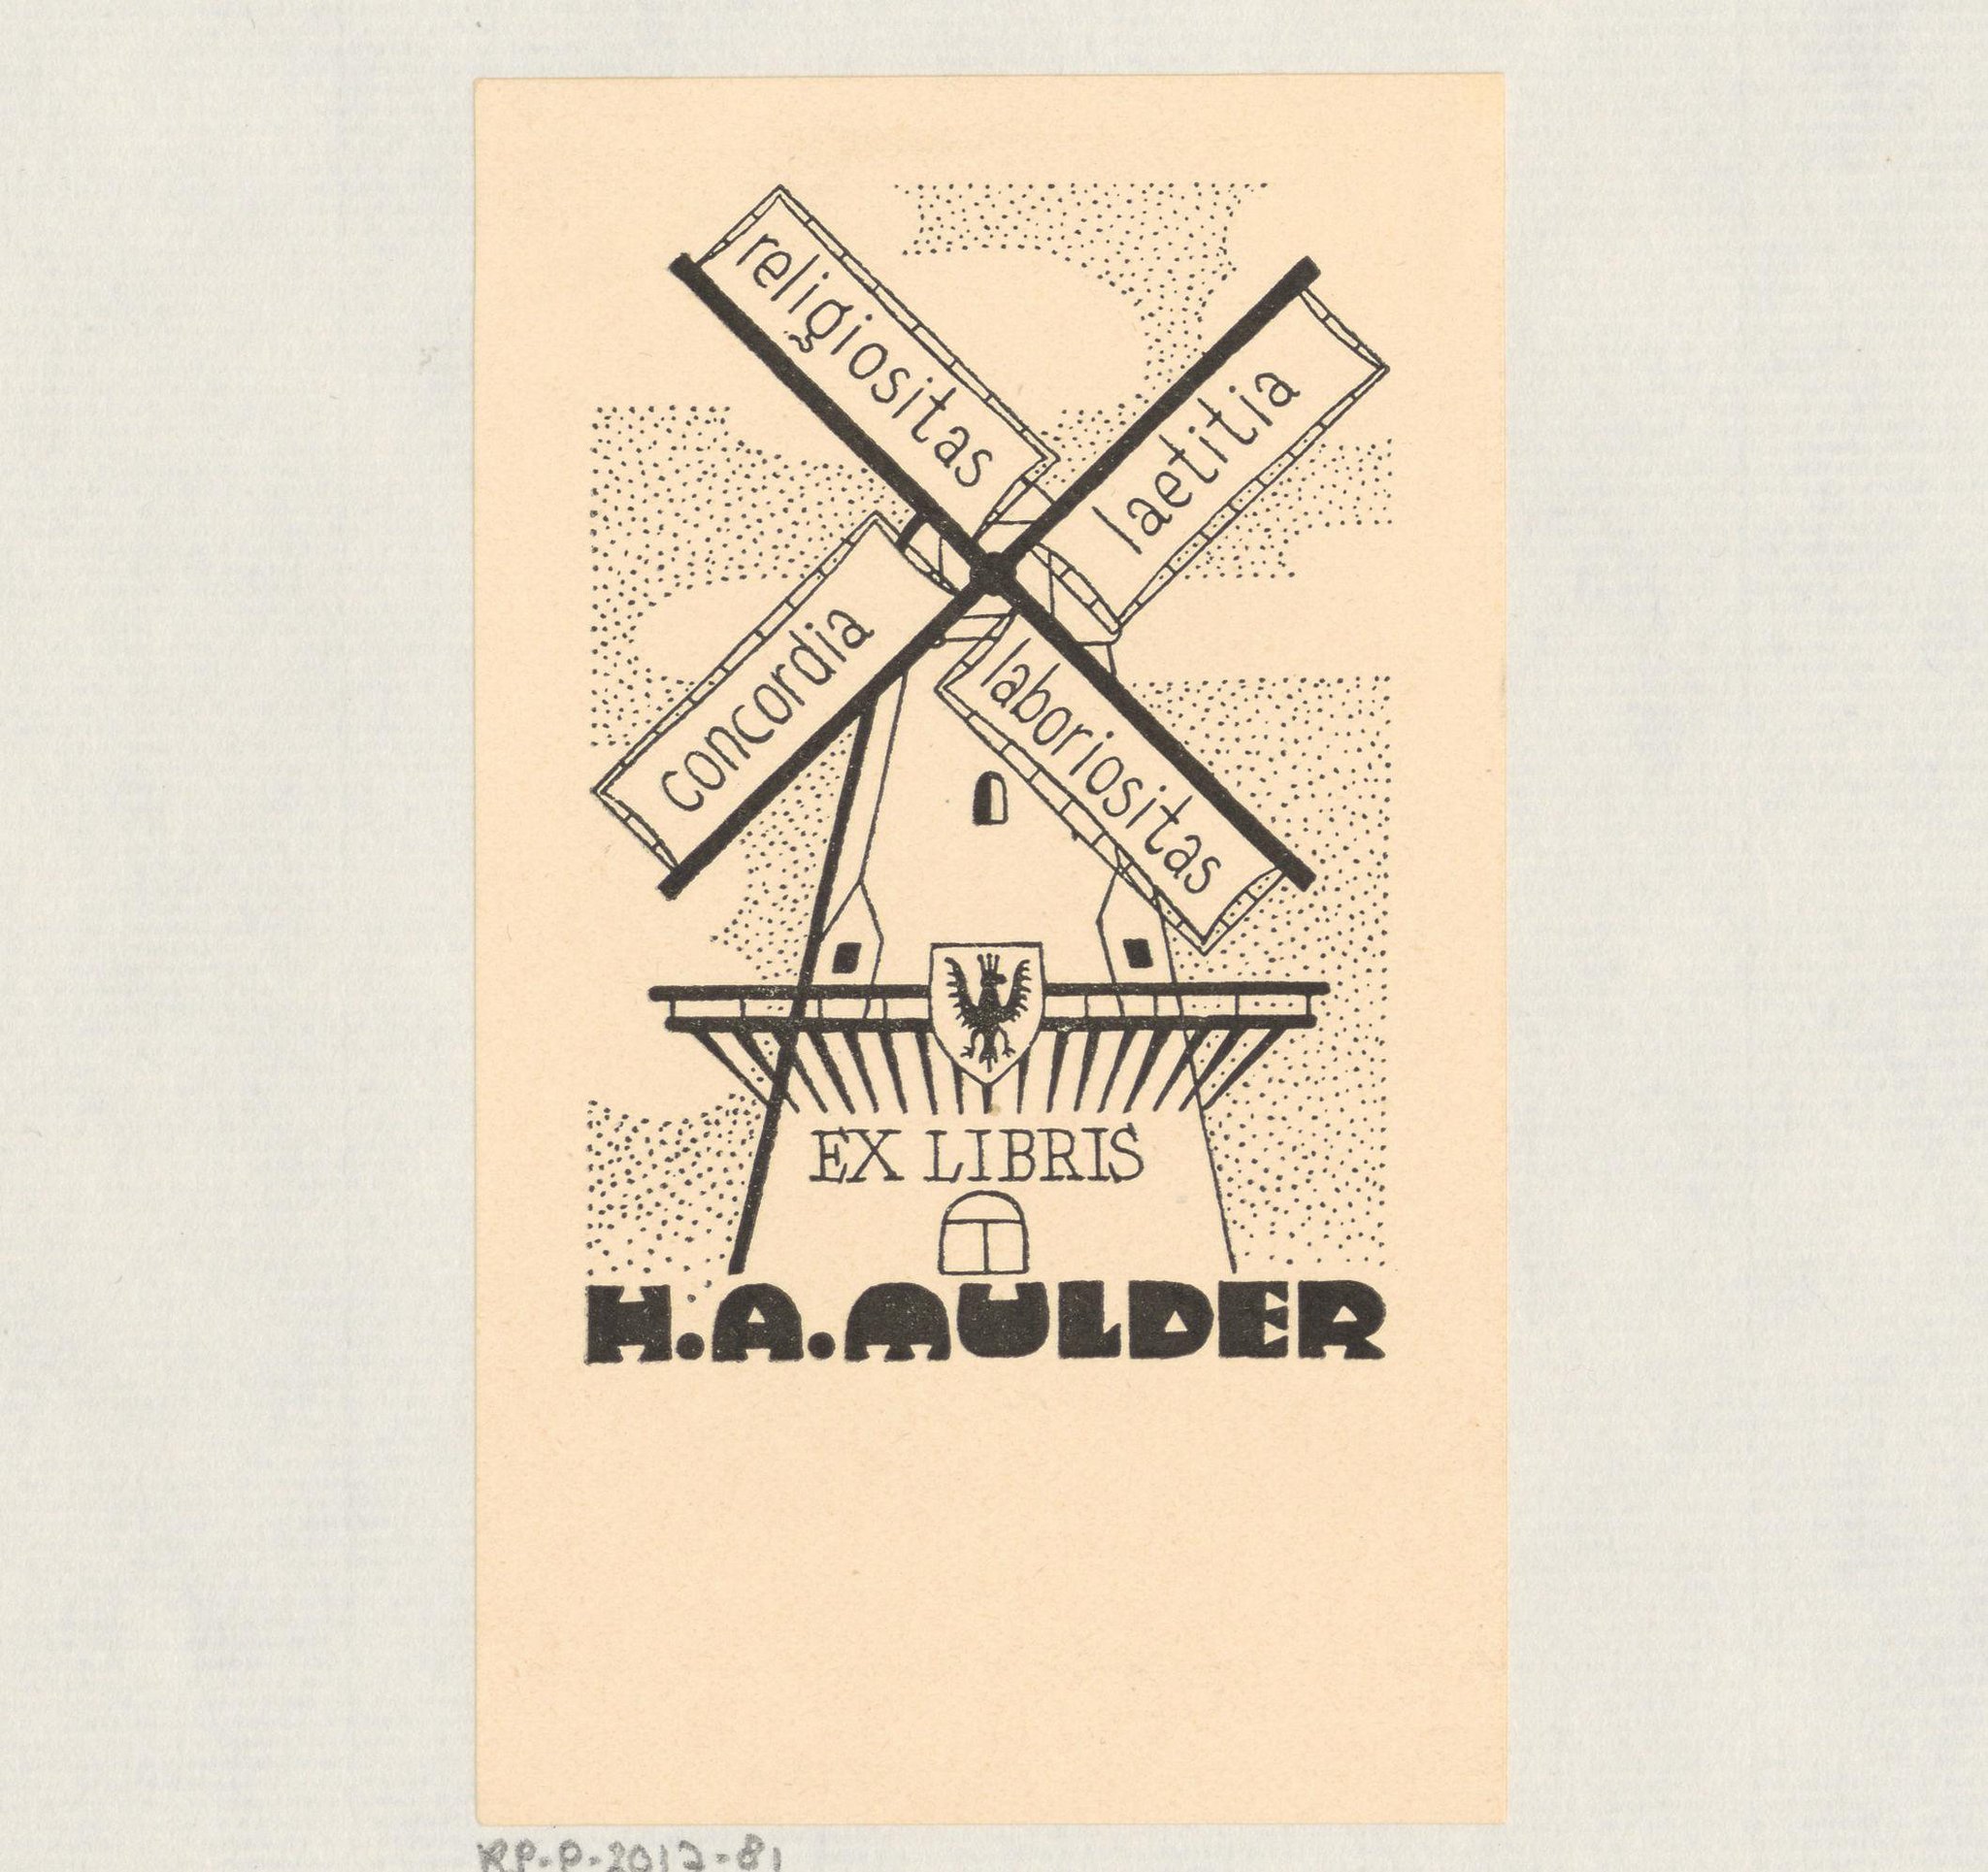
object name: bookplate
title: Ex libris van H.A. Mulder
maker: h.a. mulder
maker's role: print maker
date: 1941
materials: paper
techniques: printing block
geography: scheveningen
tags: print maker, h.a. mulder, christian religion, windmill, armorial bearing, heraldry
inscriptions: signature, date and inscription: ‘cl / ipse fecit 1941 / te Scheveningen’